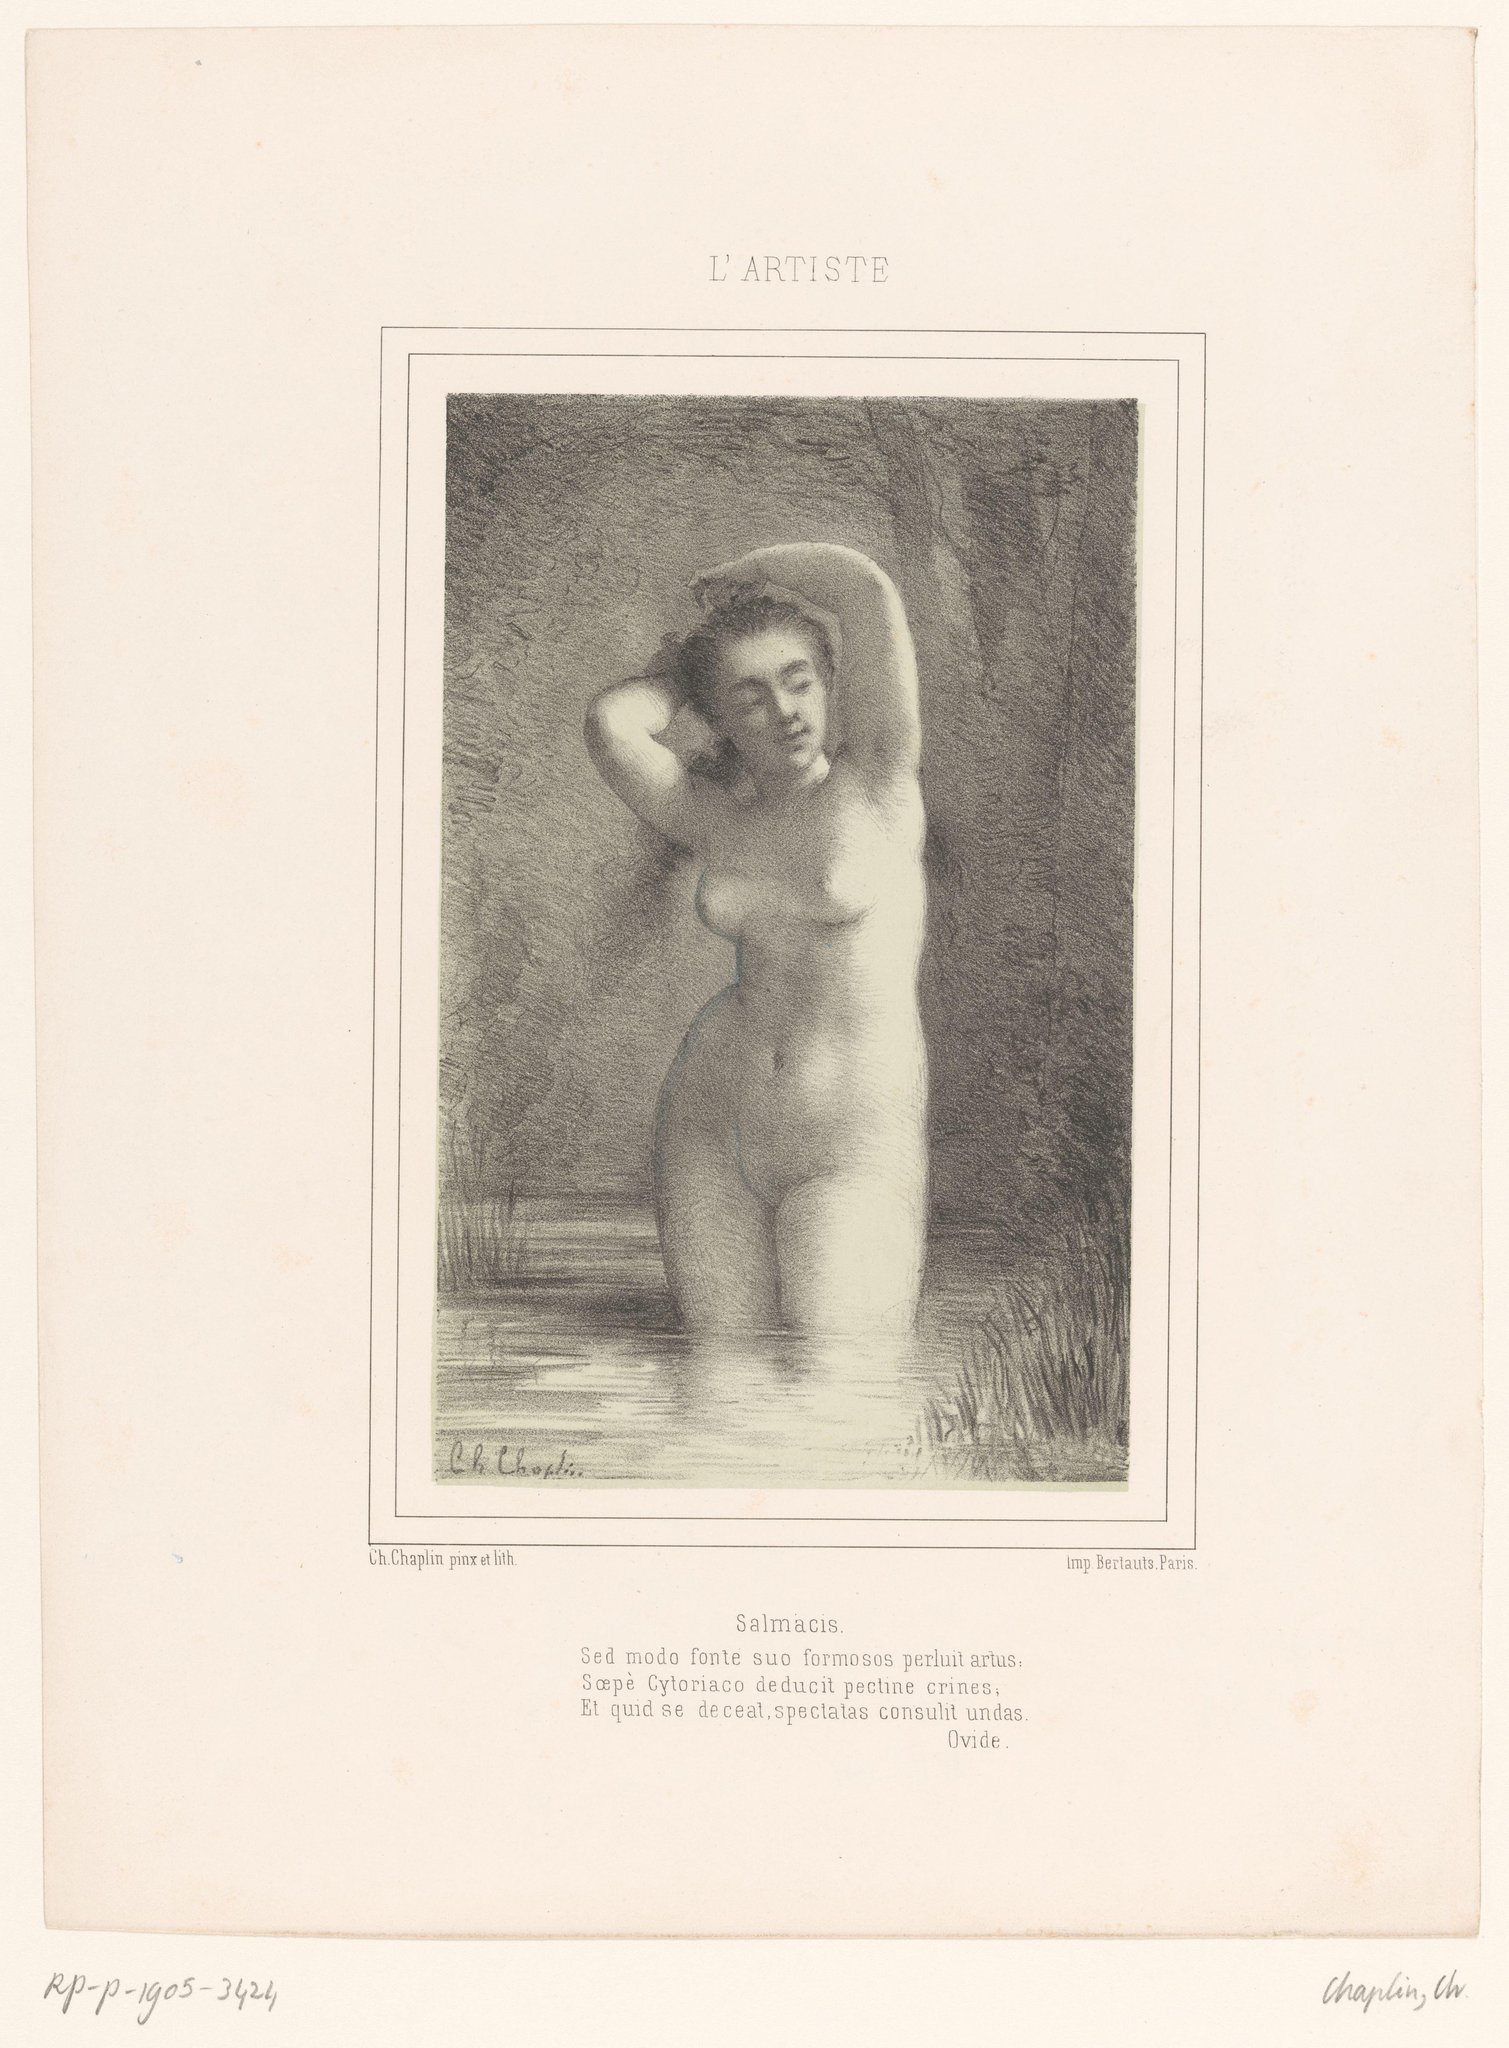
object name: print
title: Waternimf Salmacis bindt haar haren vast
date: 1861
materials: paper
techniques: tone lithography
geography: paris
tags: single named nymphs (with name)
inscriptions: collector's mark: Lugt 2228a